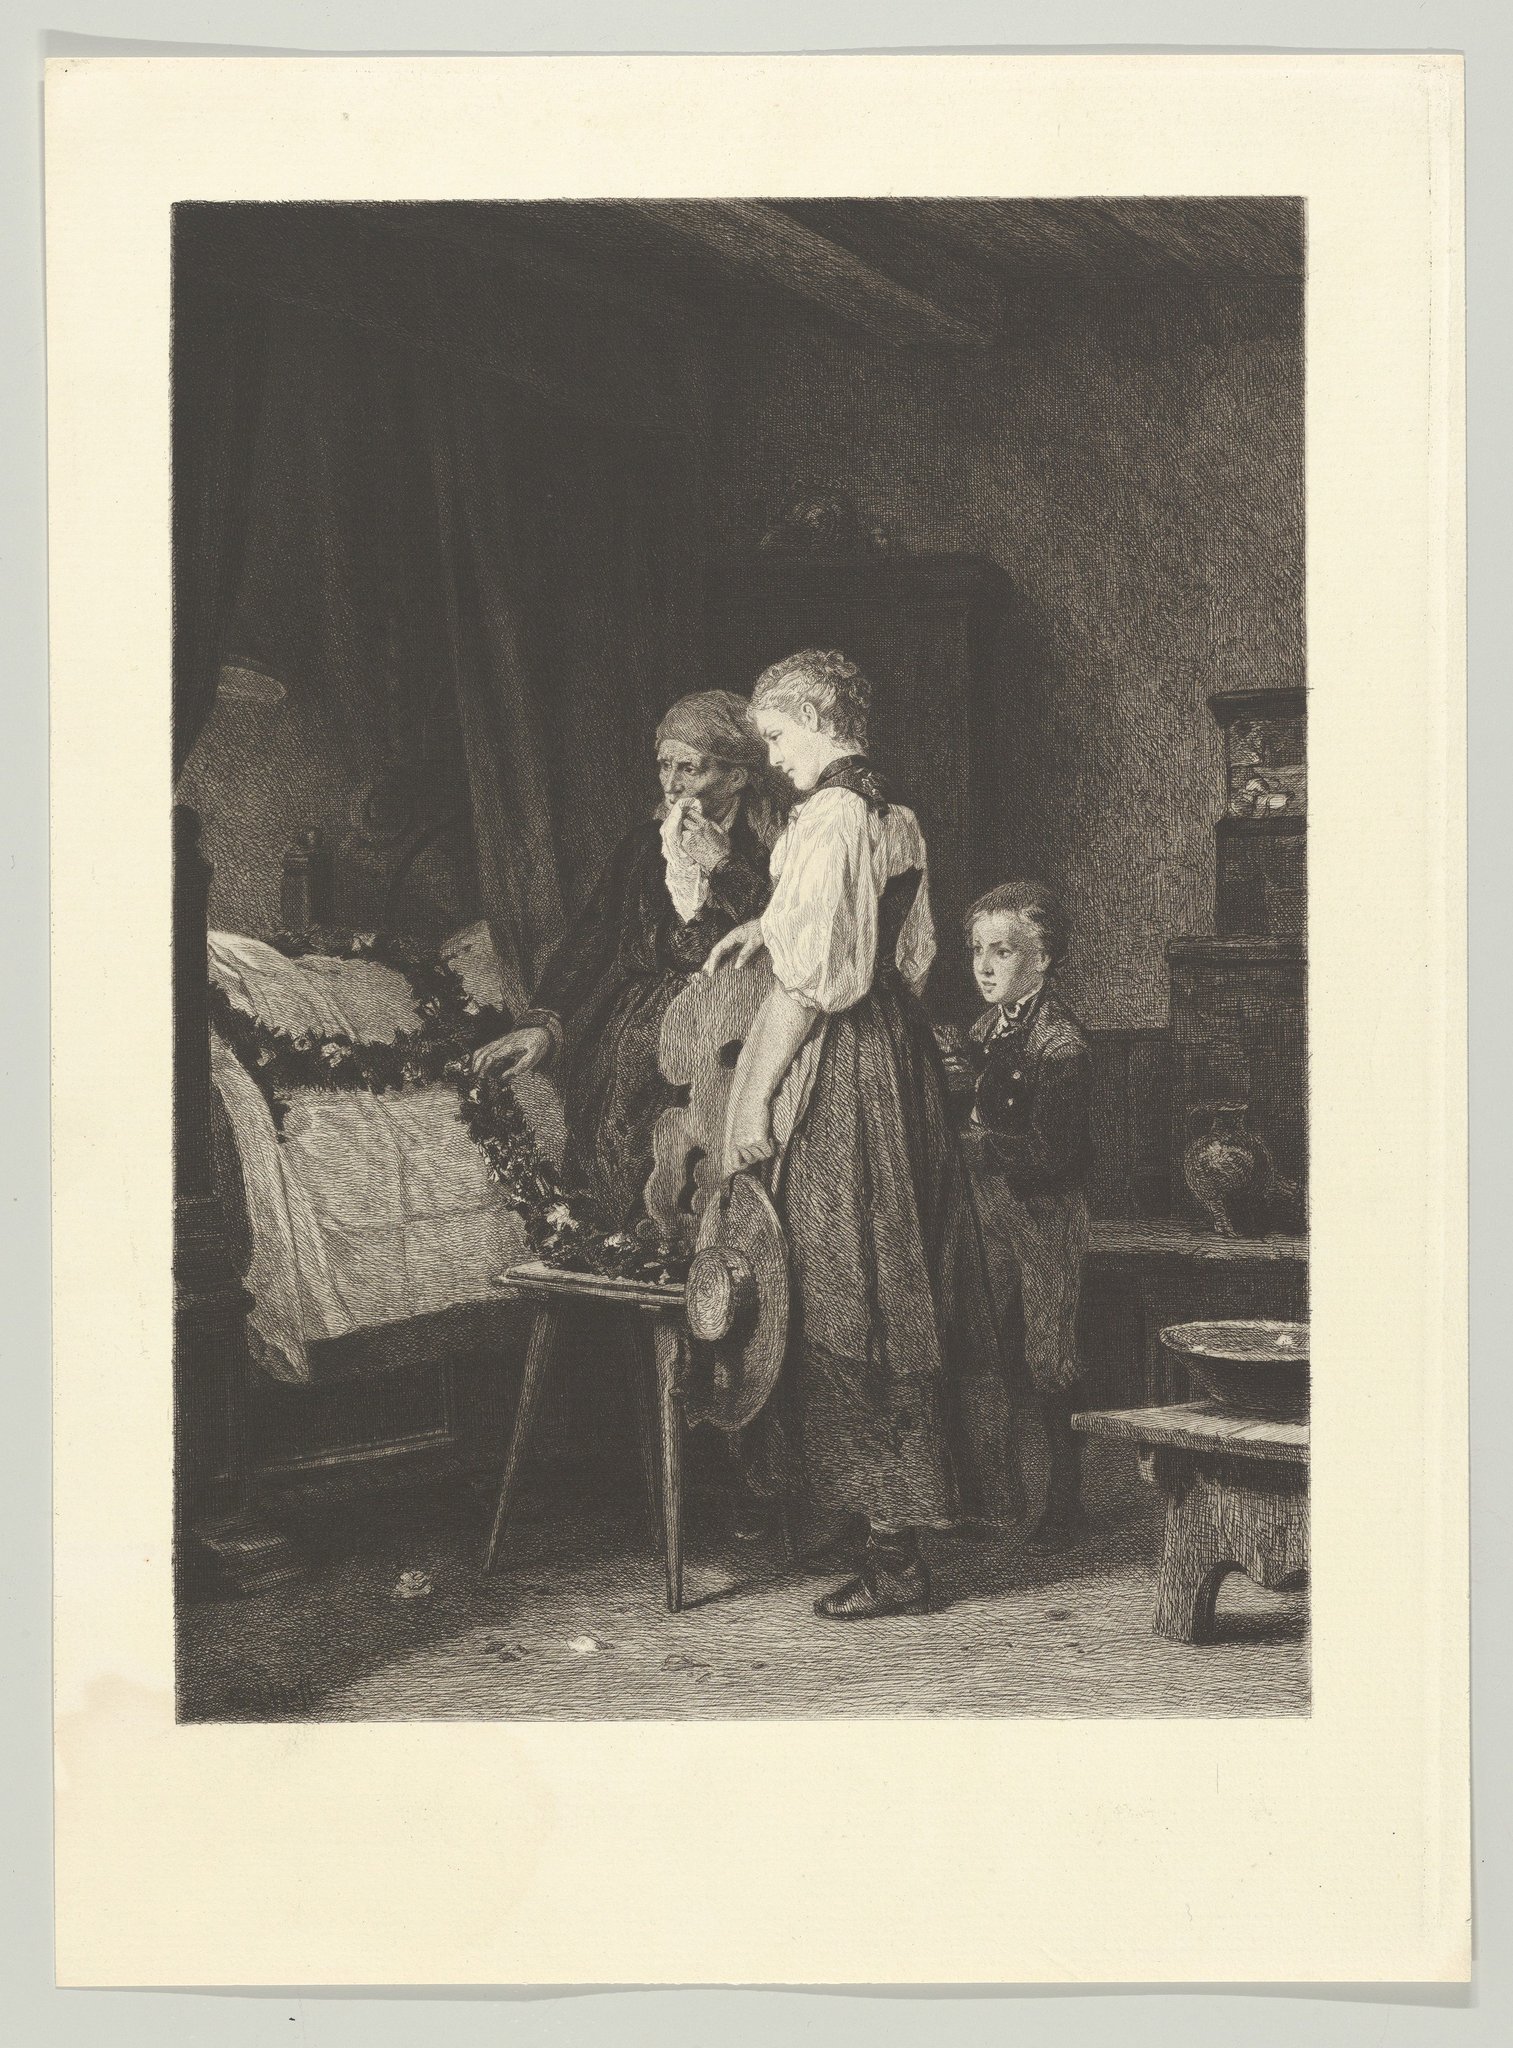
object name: print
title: In the House of Mourning, from "American Art Review", vol. 1, no. 8 (republished in "The Art Journal," October 1880)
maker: friedrich leonhard meyer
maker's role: etcher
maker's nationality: german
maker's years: 1842-1880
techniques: etching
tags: corpses,boys,women,beds